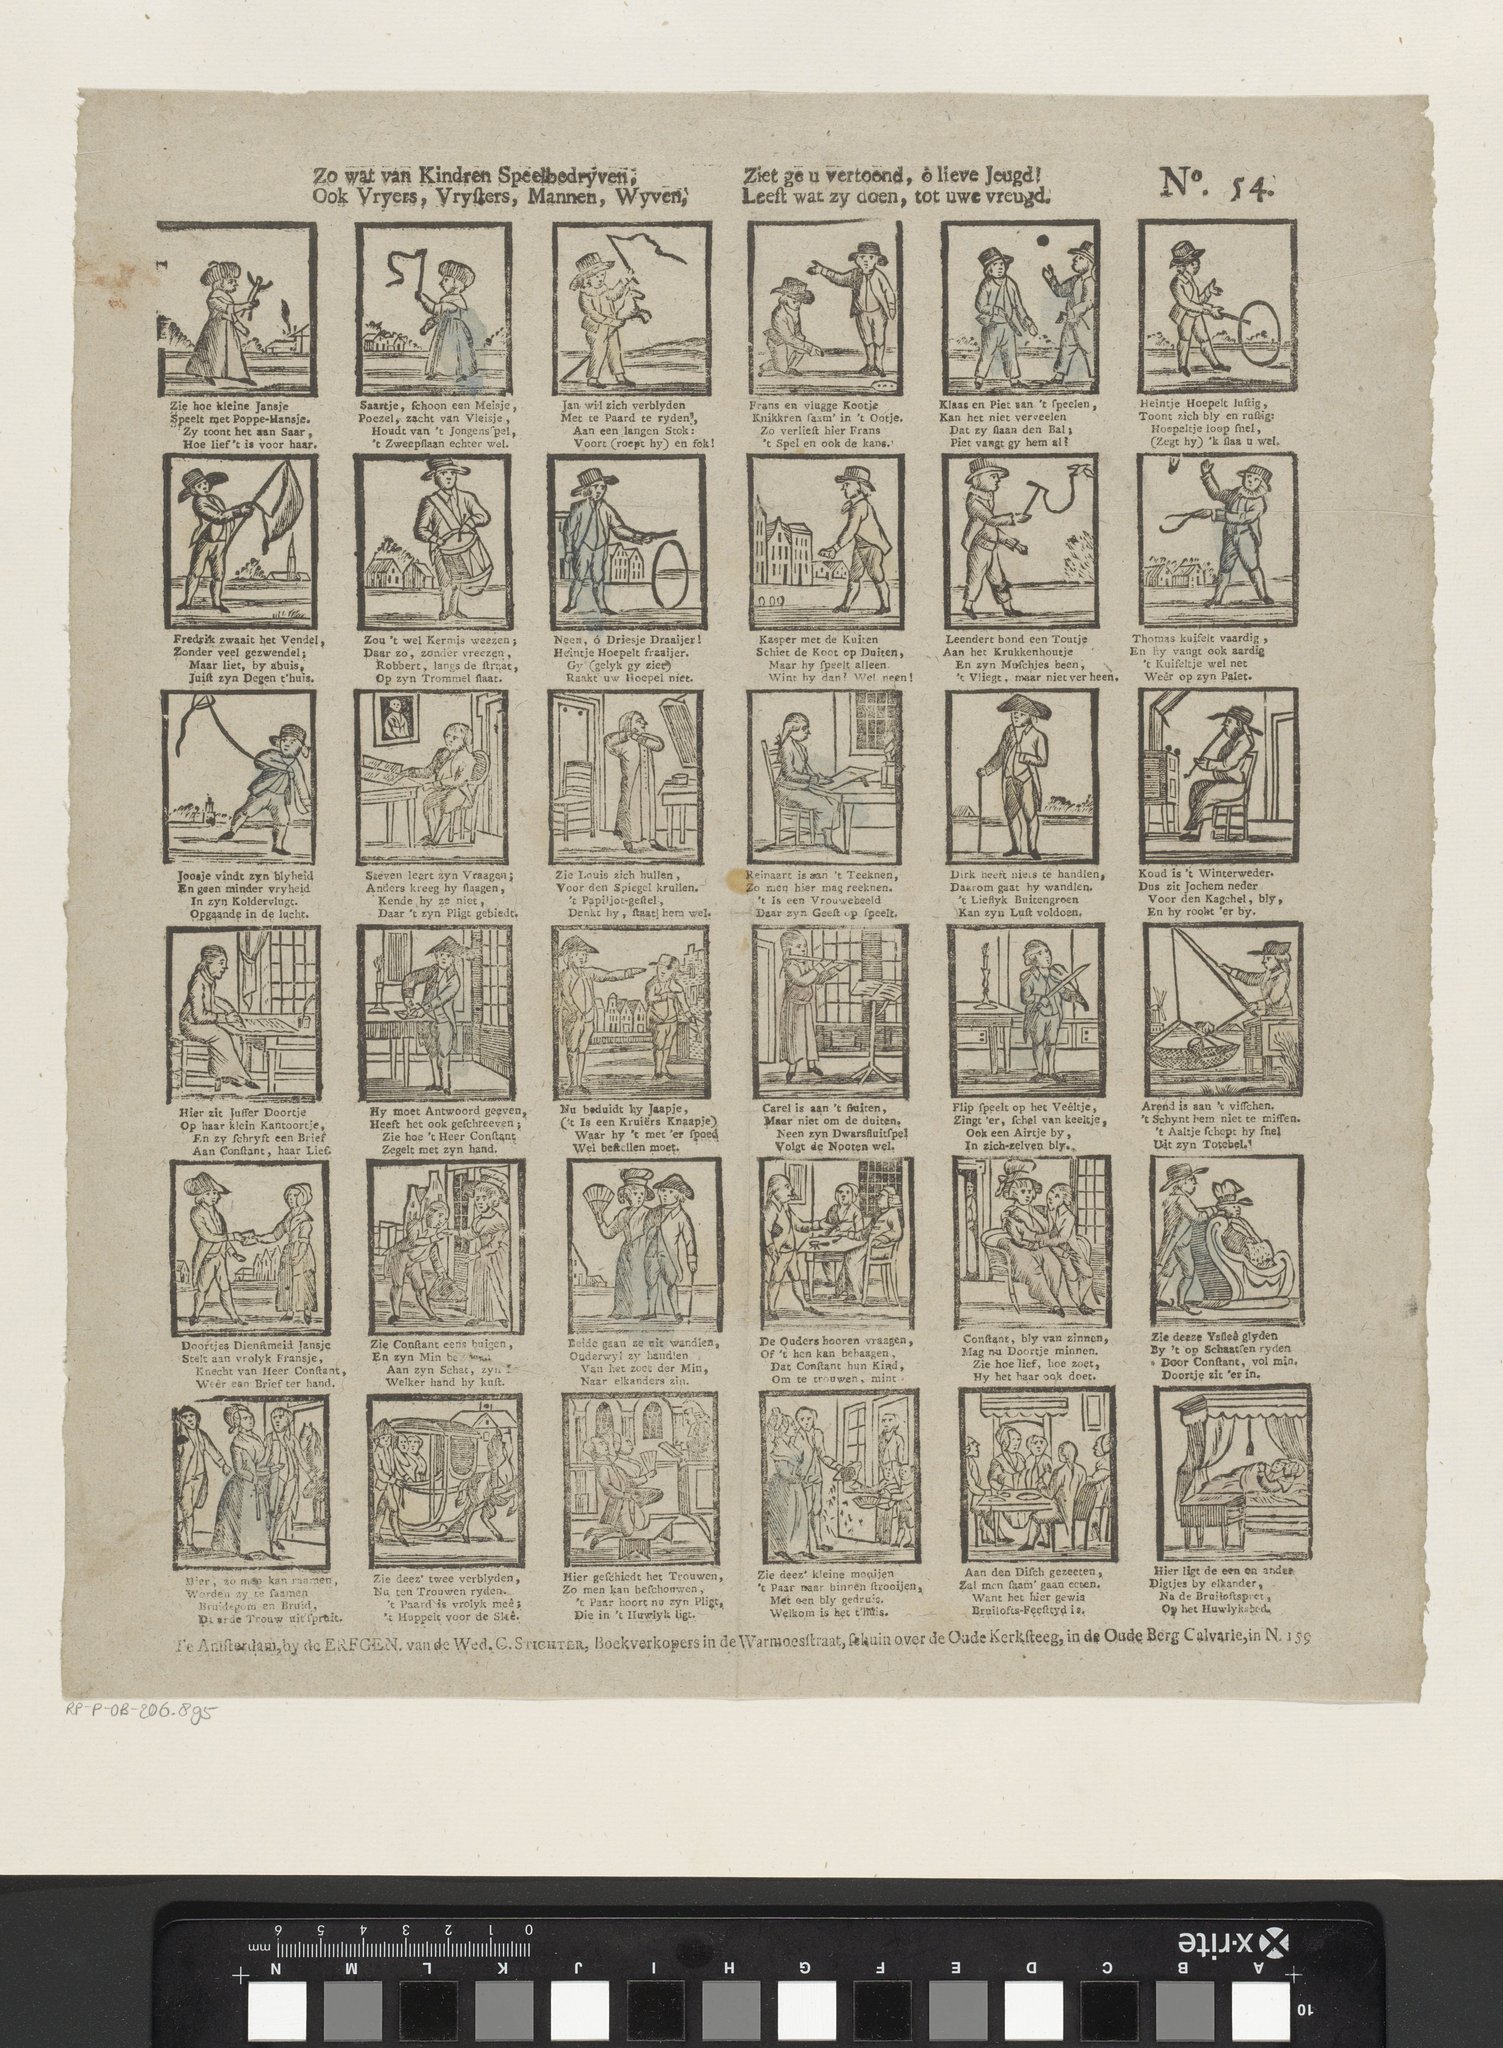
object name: popular print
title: Zo wat van kindren speelbedryven, / Ook vryers, vrysters, mannen, wyven, / Ziet ge u vertoond, ô lieve jeugd! / Leest wat zy doen, tot uwe vreugd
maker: Anonymous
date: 1770-1797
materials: paper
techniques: colour, letterpress printing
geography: netherlands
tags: children's games and plays, (flying a) kite, games using special objects (marbles, top, hoop, etc.)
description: Blad met 36 voorstellingen van kinderspelen en bezigheden, zoals stokpaardje rijden, hoepelen, vliegeren en vissen. Onder elke afbeelding een vierregelig vers. Genummerd rechtsboven: No. 54.